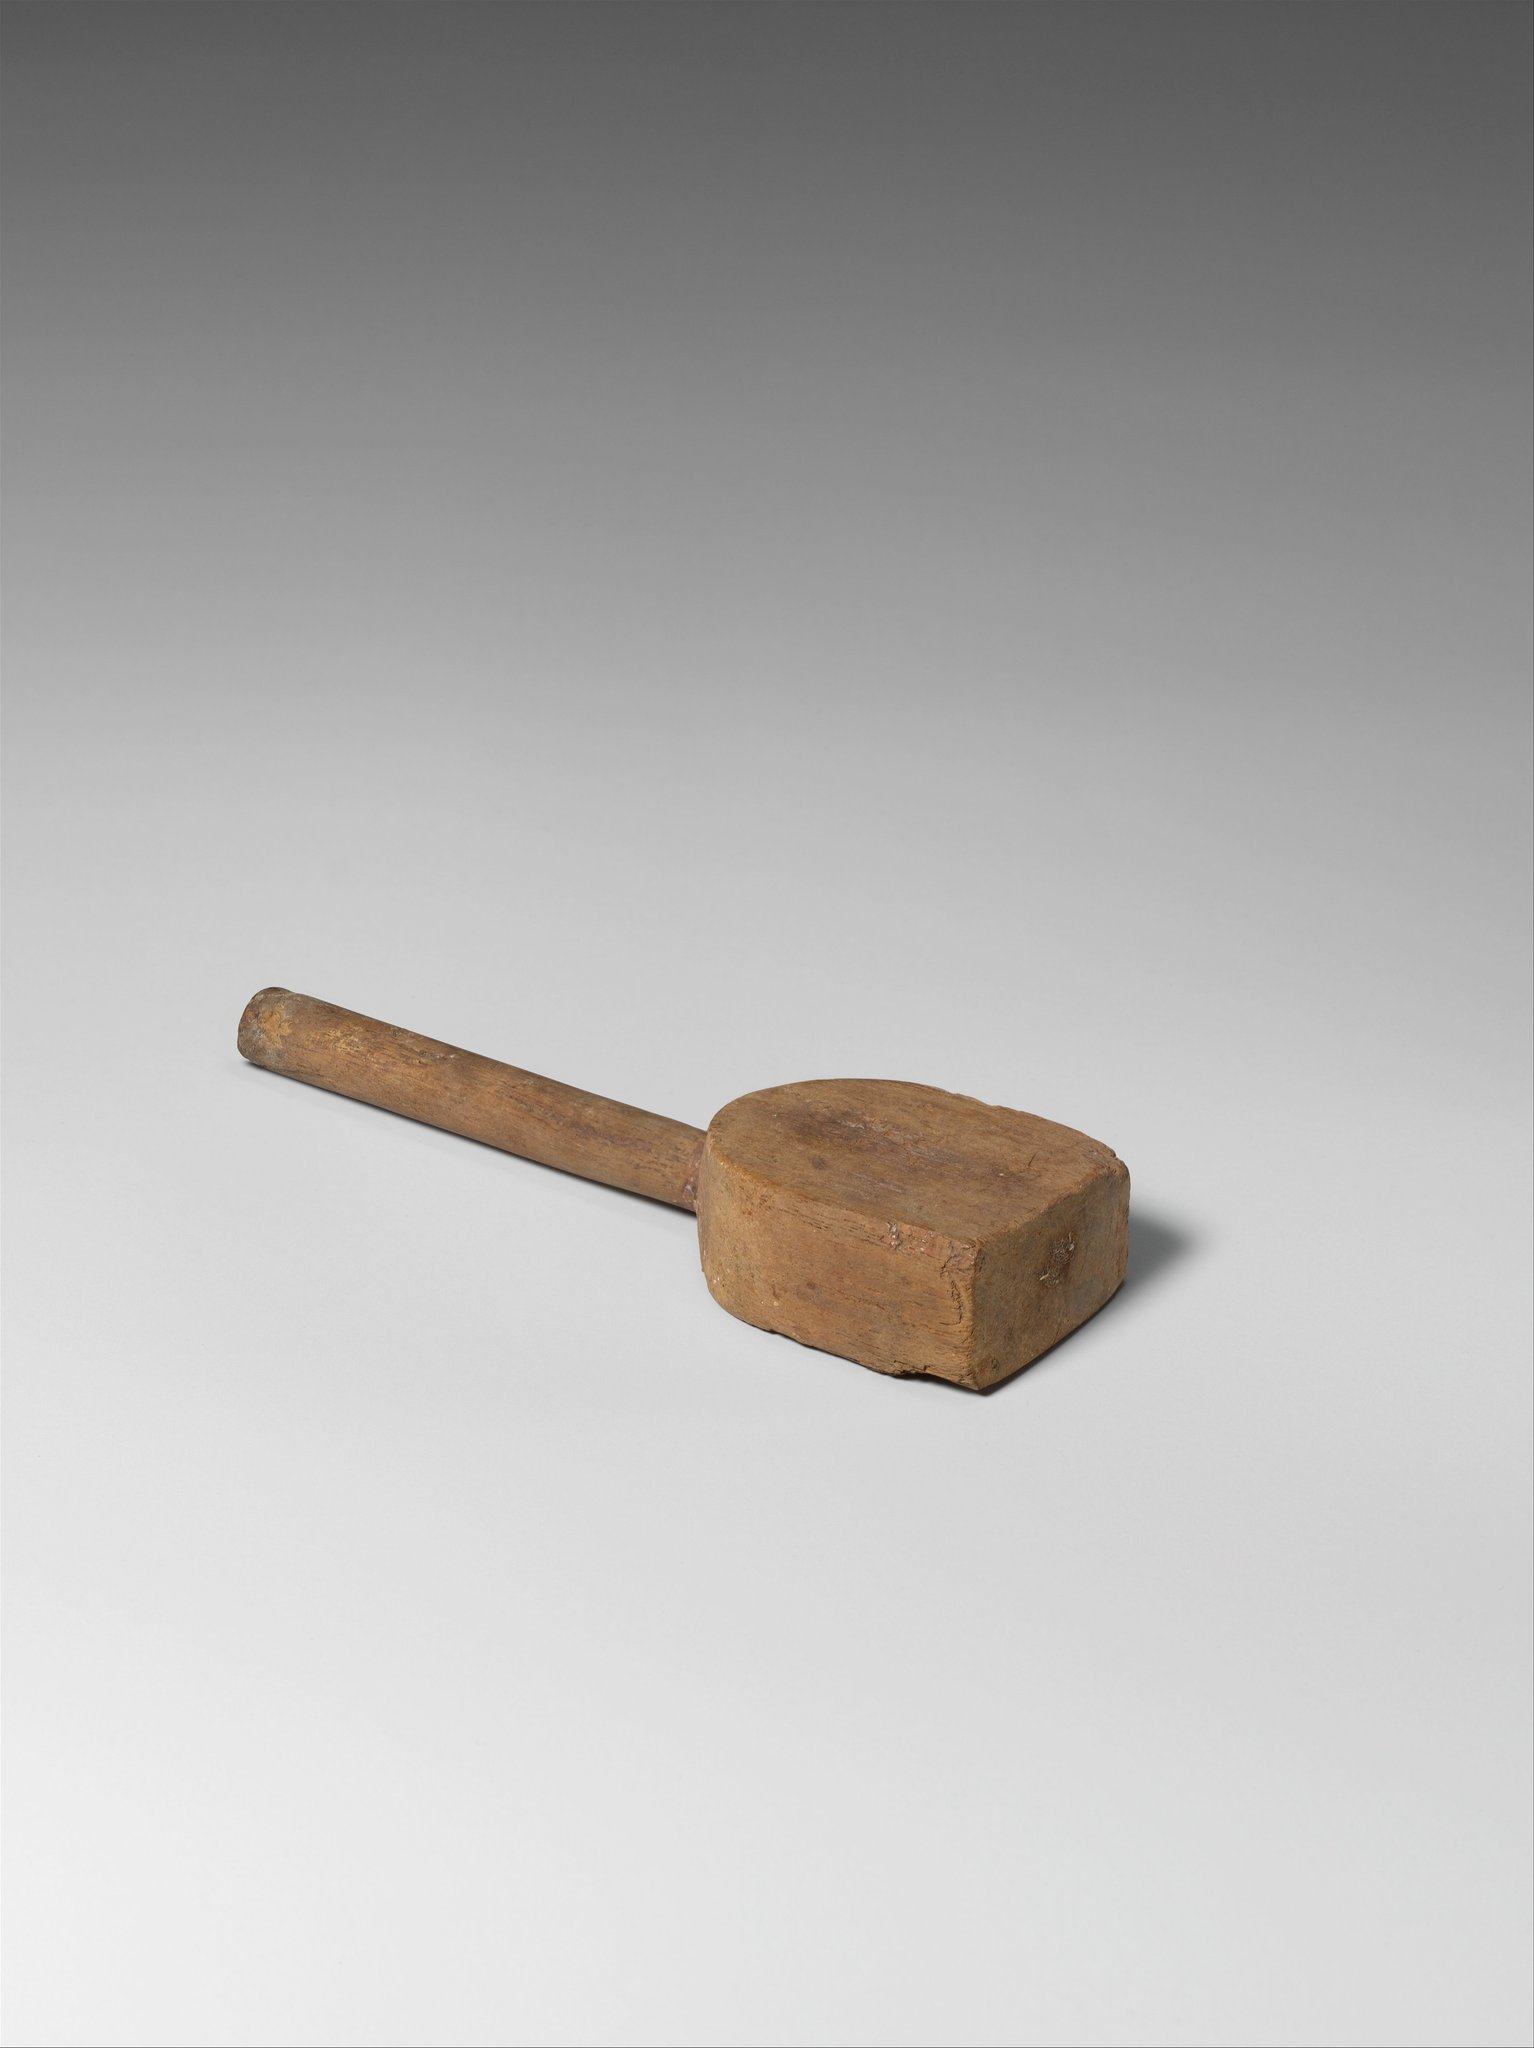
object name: burnisher, polishing tool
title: Papyrus burnisher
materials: wood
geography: egypt